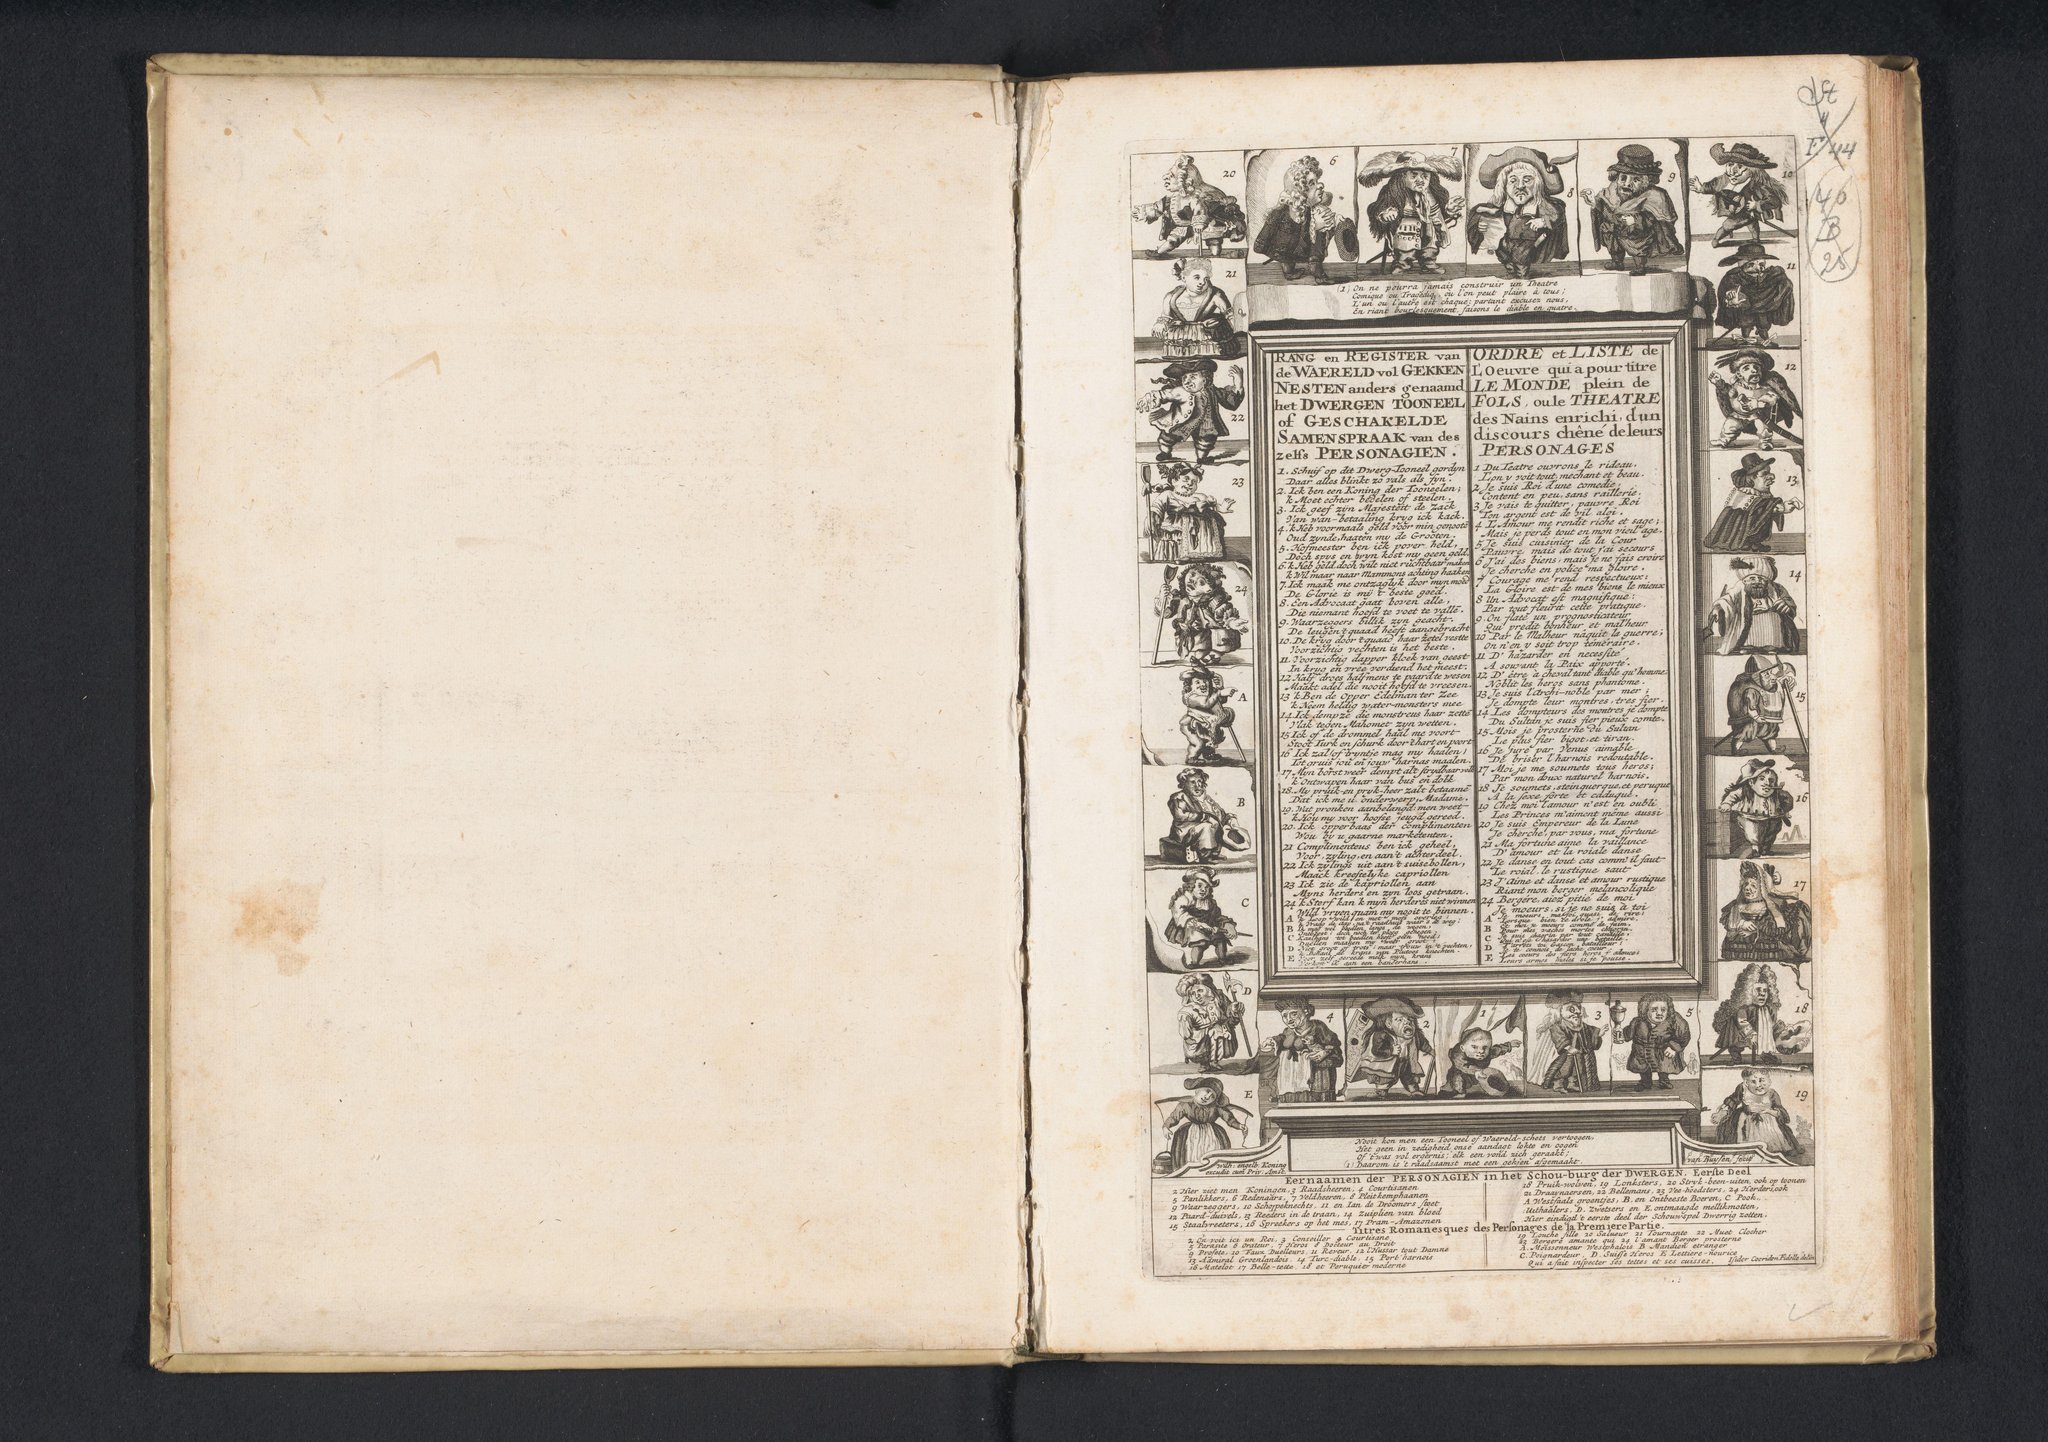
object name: caricature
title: Bombario Actionist en de Geest van Esopus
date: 1718-1720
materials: paper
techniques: etching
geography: amsterdam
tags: caricatures (human types), little people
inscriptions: collector's mark: Lugt 2166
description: Eerste register voor de prenten 1-24 en A-E in de serie getiteld: Bombario Actionist en de Geest van Esopus. Register met in twee kolommen lijsten van de prenten genummerd 1-24 en A-E in het Nederlands en Frans. Afdruk binnen een omlijsting met verkleinde weergaven van de kleine mensen in volgende prenten, gedrukt van een aparte plaat. Onderdeel van de tweede Nederlandse gebonden uitgave uit 1720 (en gerelateerd aan de Windhandel in dat jaar) van een serie karikaturen van kleine mensen, bekend als Het Dwergentooneel, deels gekopieerd naar een ouder Duits voorbeeld.